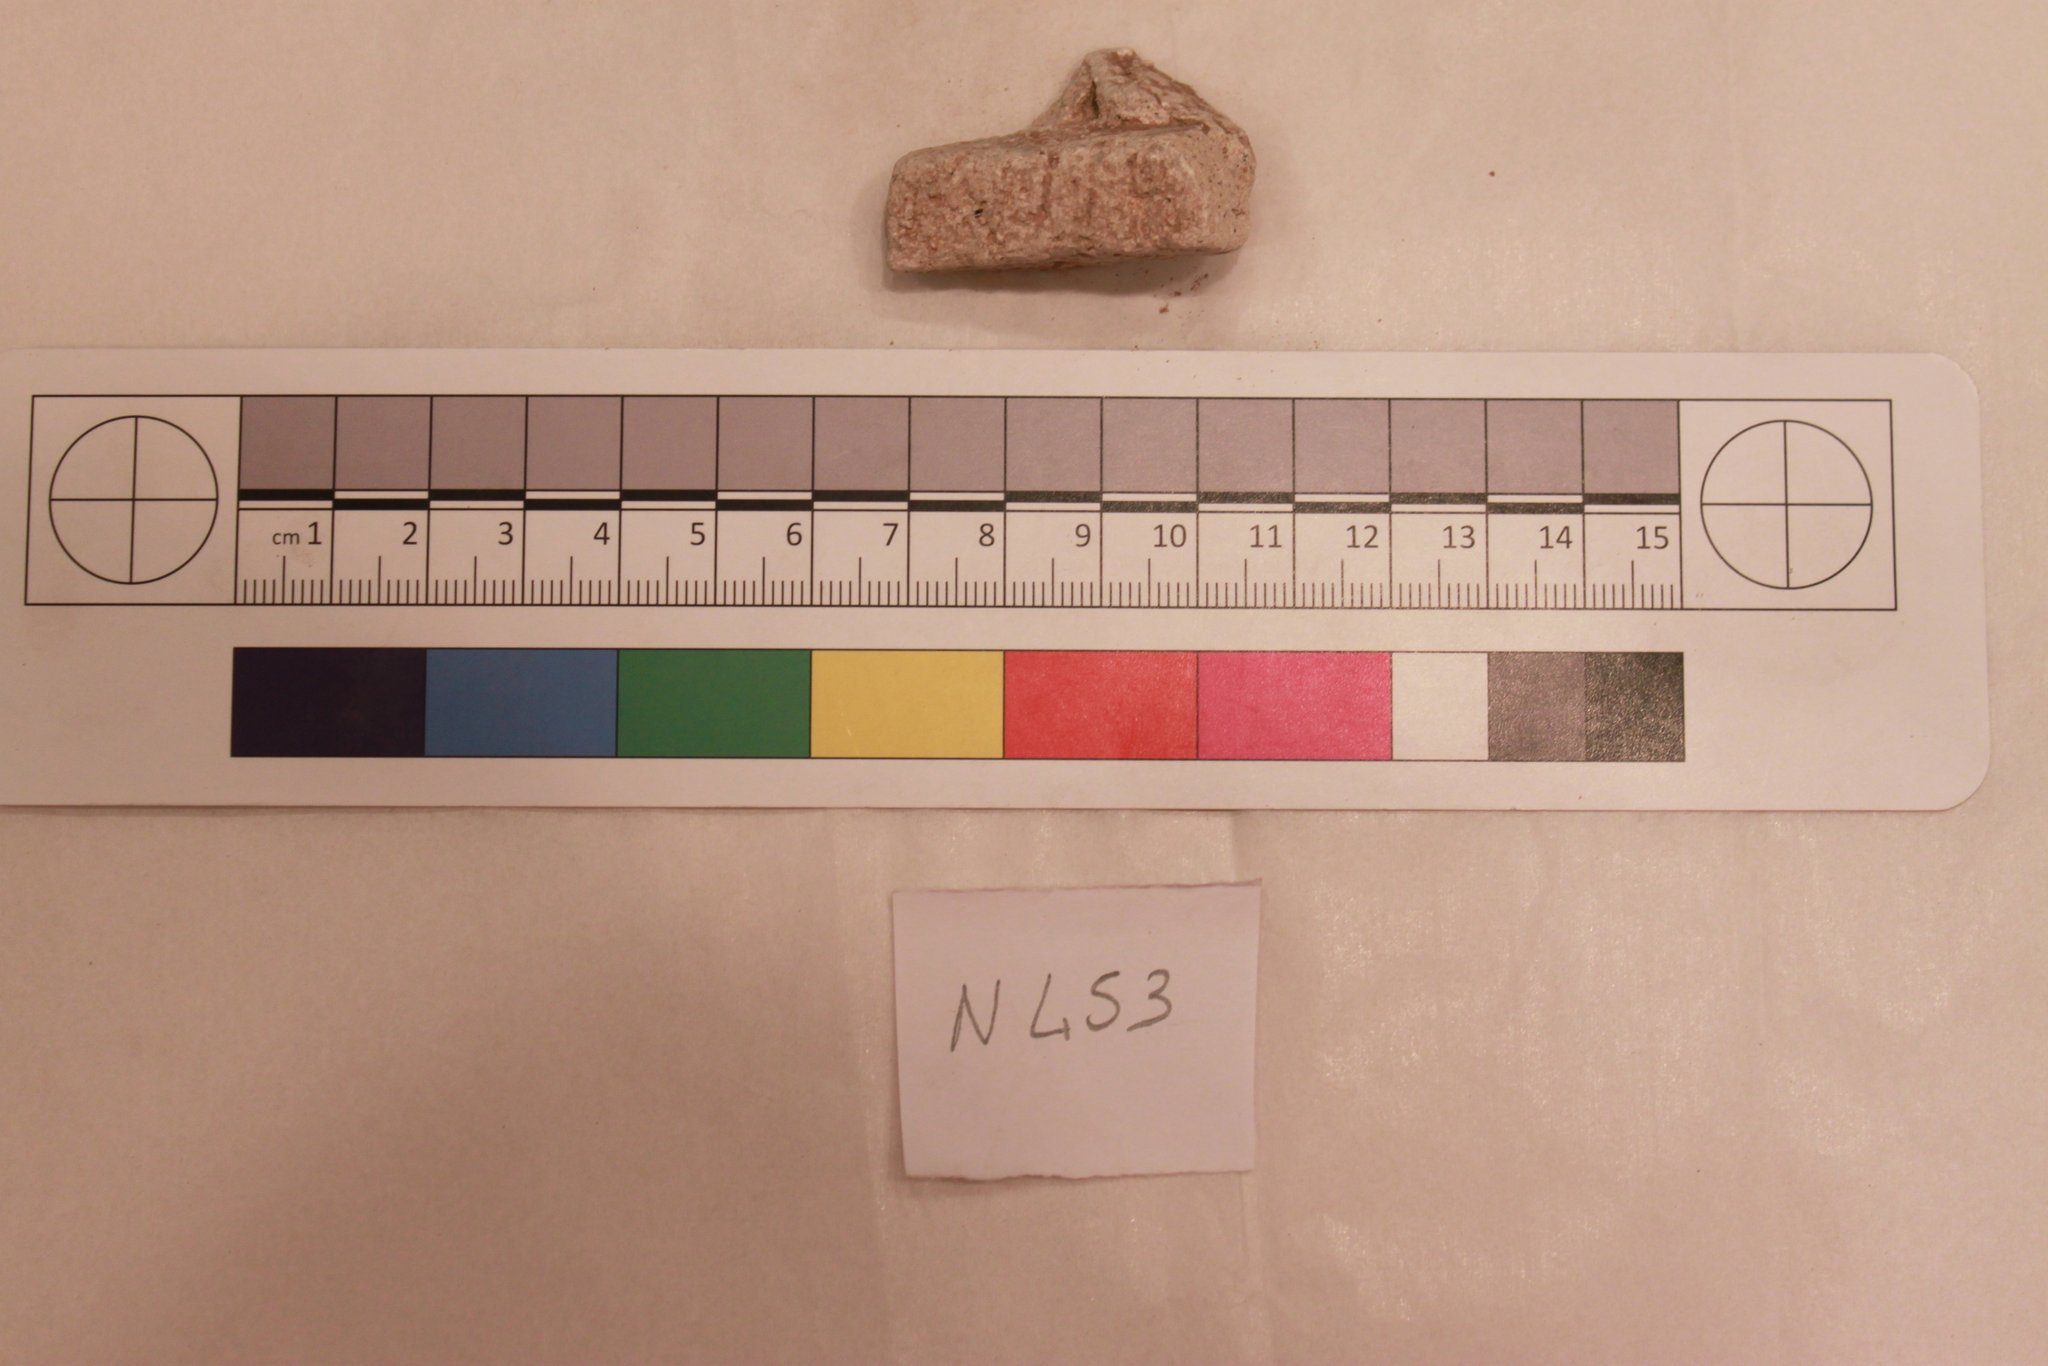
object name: fragment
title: Stucco Fragment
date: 701-1200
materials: plaster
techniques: carving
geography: iran